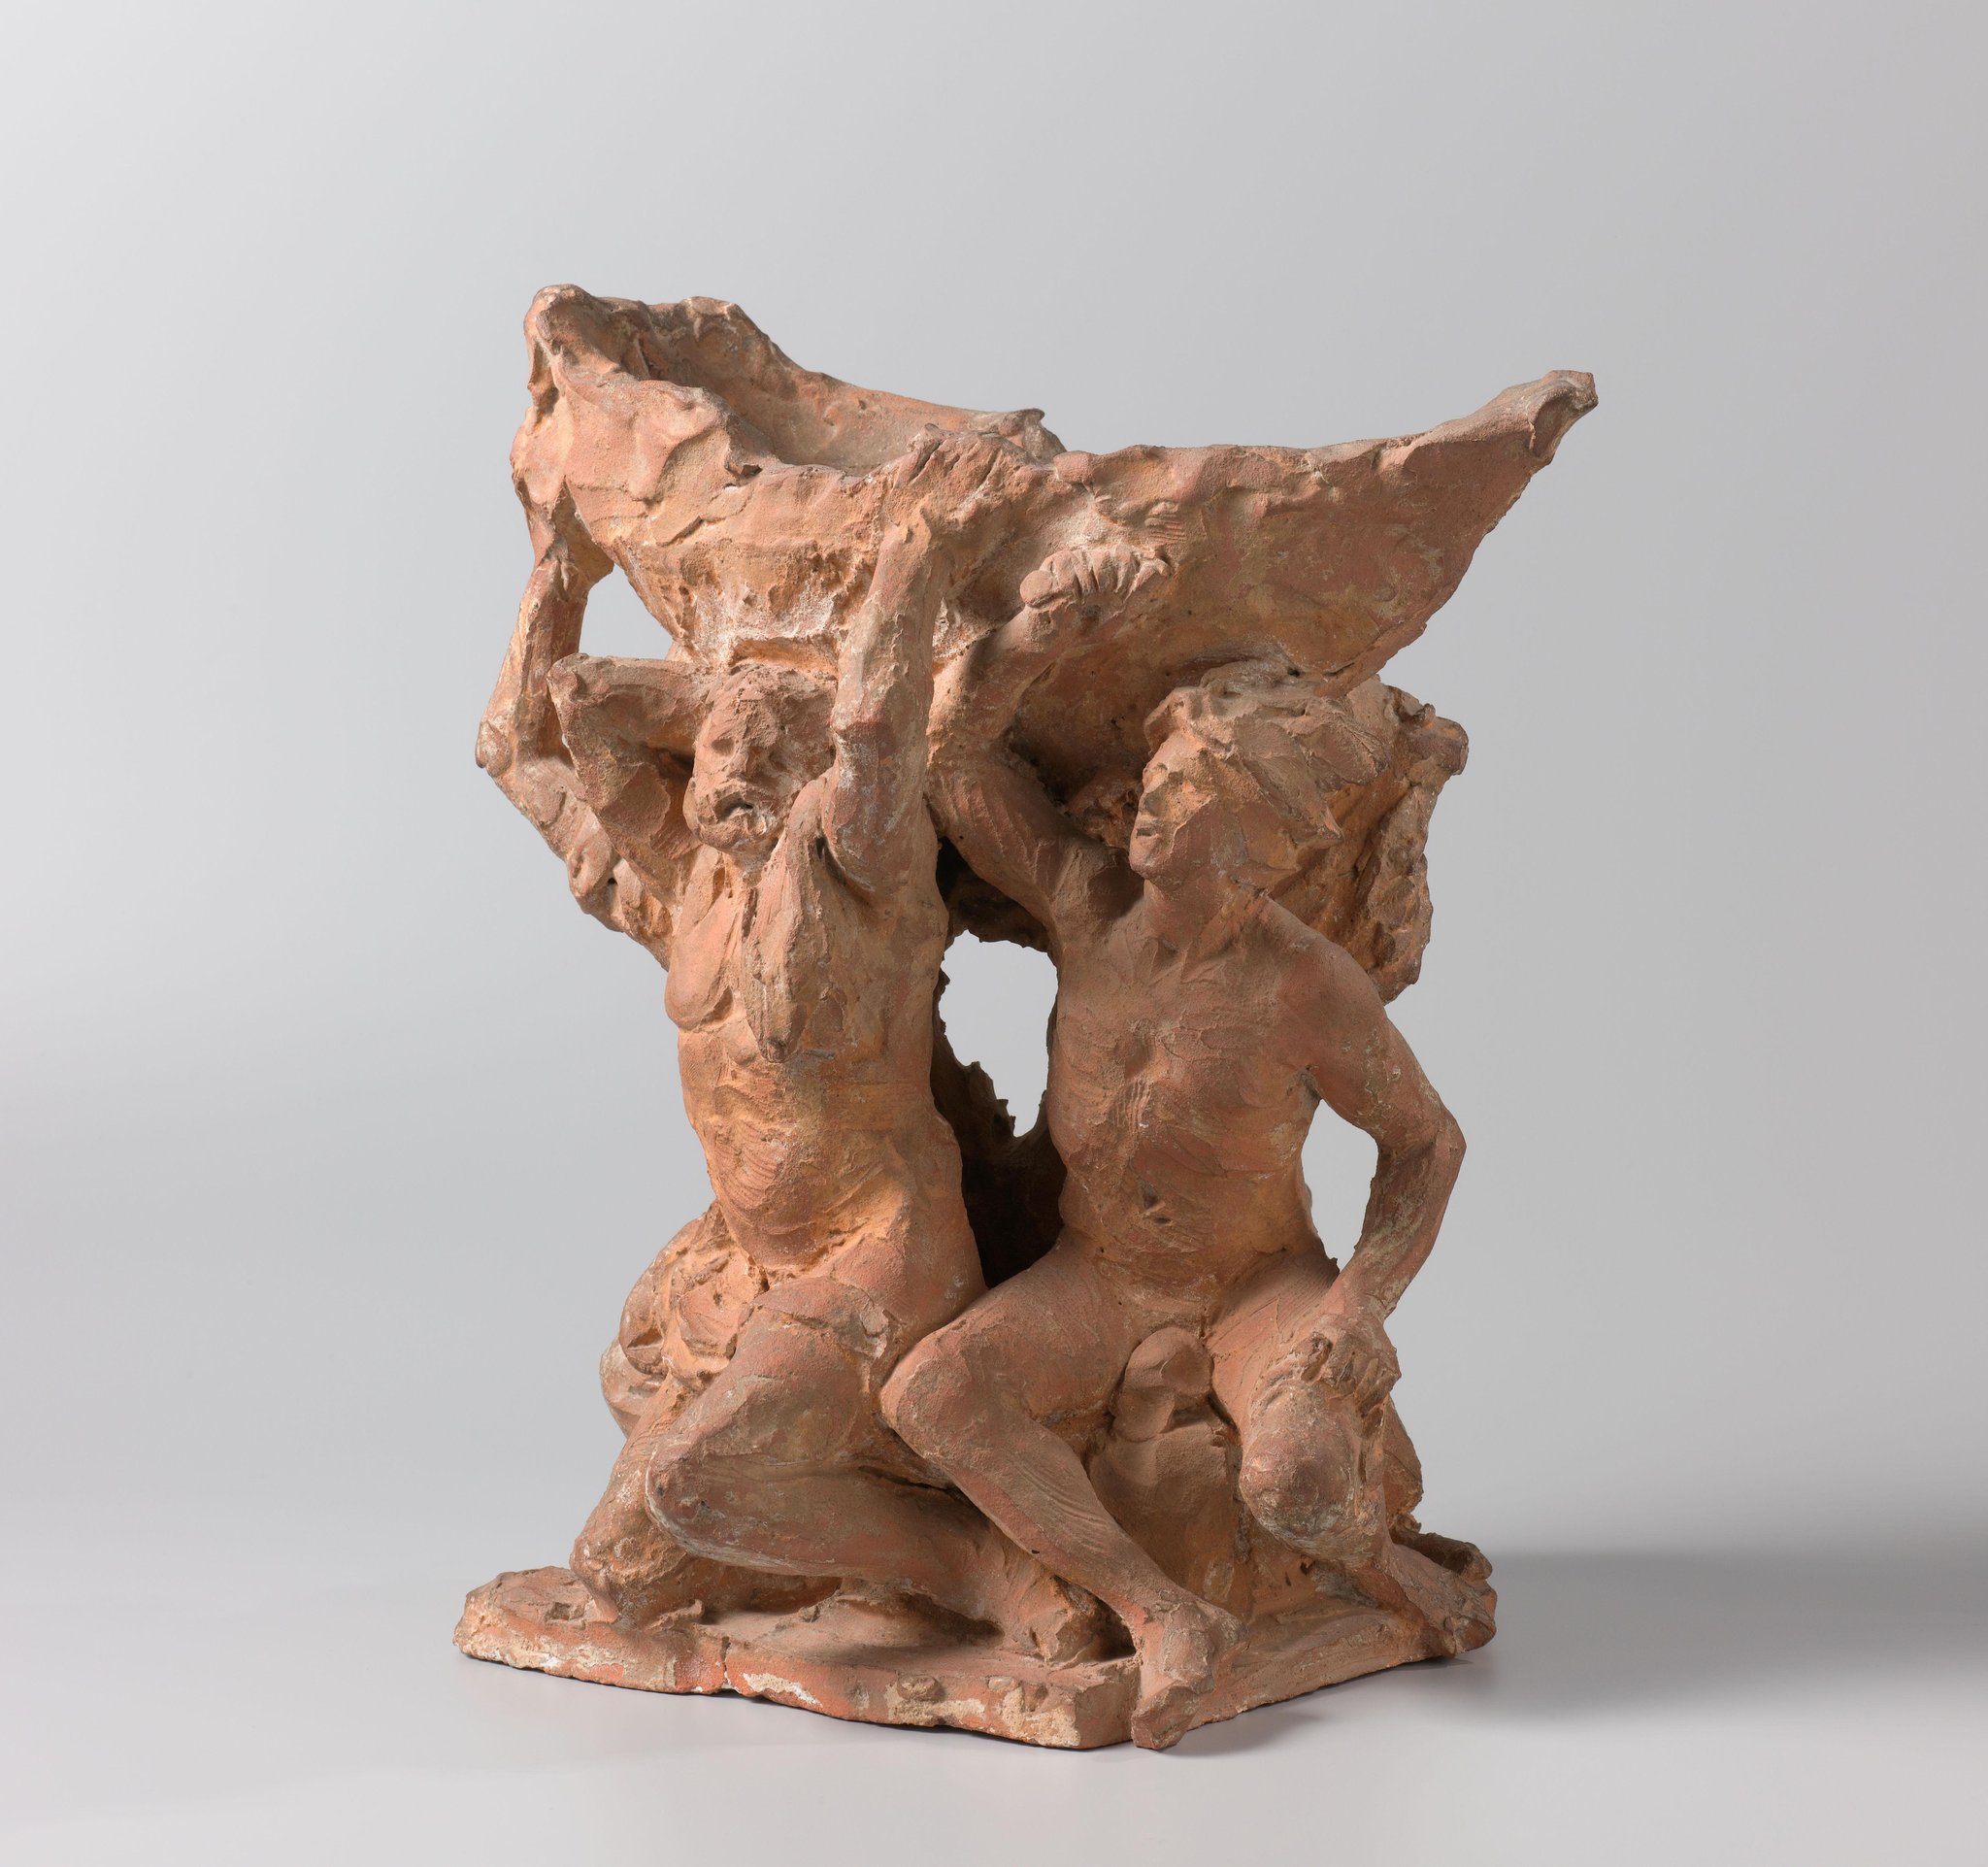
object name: model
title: The ‘Amsterdam Cog’ Borne by Mercury, Hercules, Minerva and Neptune, Model for the Crowning Element of a Pump Designed for the Courtyard of the Amsterdam Town Hall (now Royal Palace) at Dam Square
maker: artus quellinus (i)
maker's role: draughtsman, print maker, sculptor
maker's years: 1609-1668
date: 1651-1652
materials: terracotta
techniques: modeling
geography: amsterdam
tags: (story of) neptune (poseidon), (story of) hercules (heracles), sailing-ship, sailing-boat (with name), (story of) minerva (pallas, athena), (story of) mercury (hermes), amsterdam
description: Visible traces of the sculptor can be discerned in this freely modelled bozzetto (clay sketch) for the crowning element of a pump: fingerprints, sharp, deep grooves and tiny holes made by the sculpting tools to suggest depth, and short parallel lines from a serrated spatula to enliven the surface. These accents are comparable to hatching in drawings.